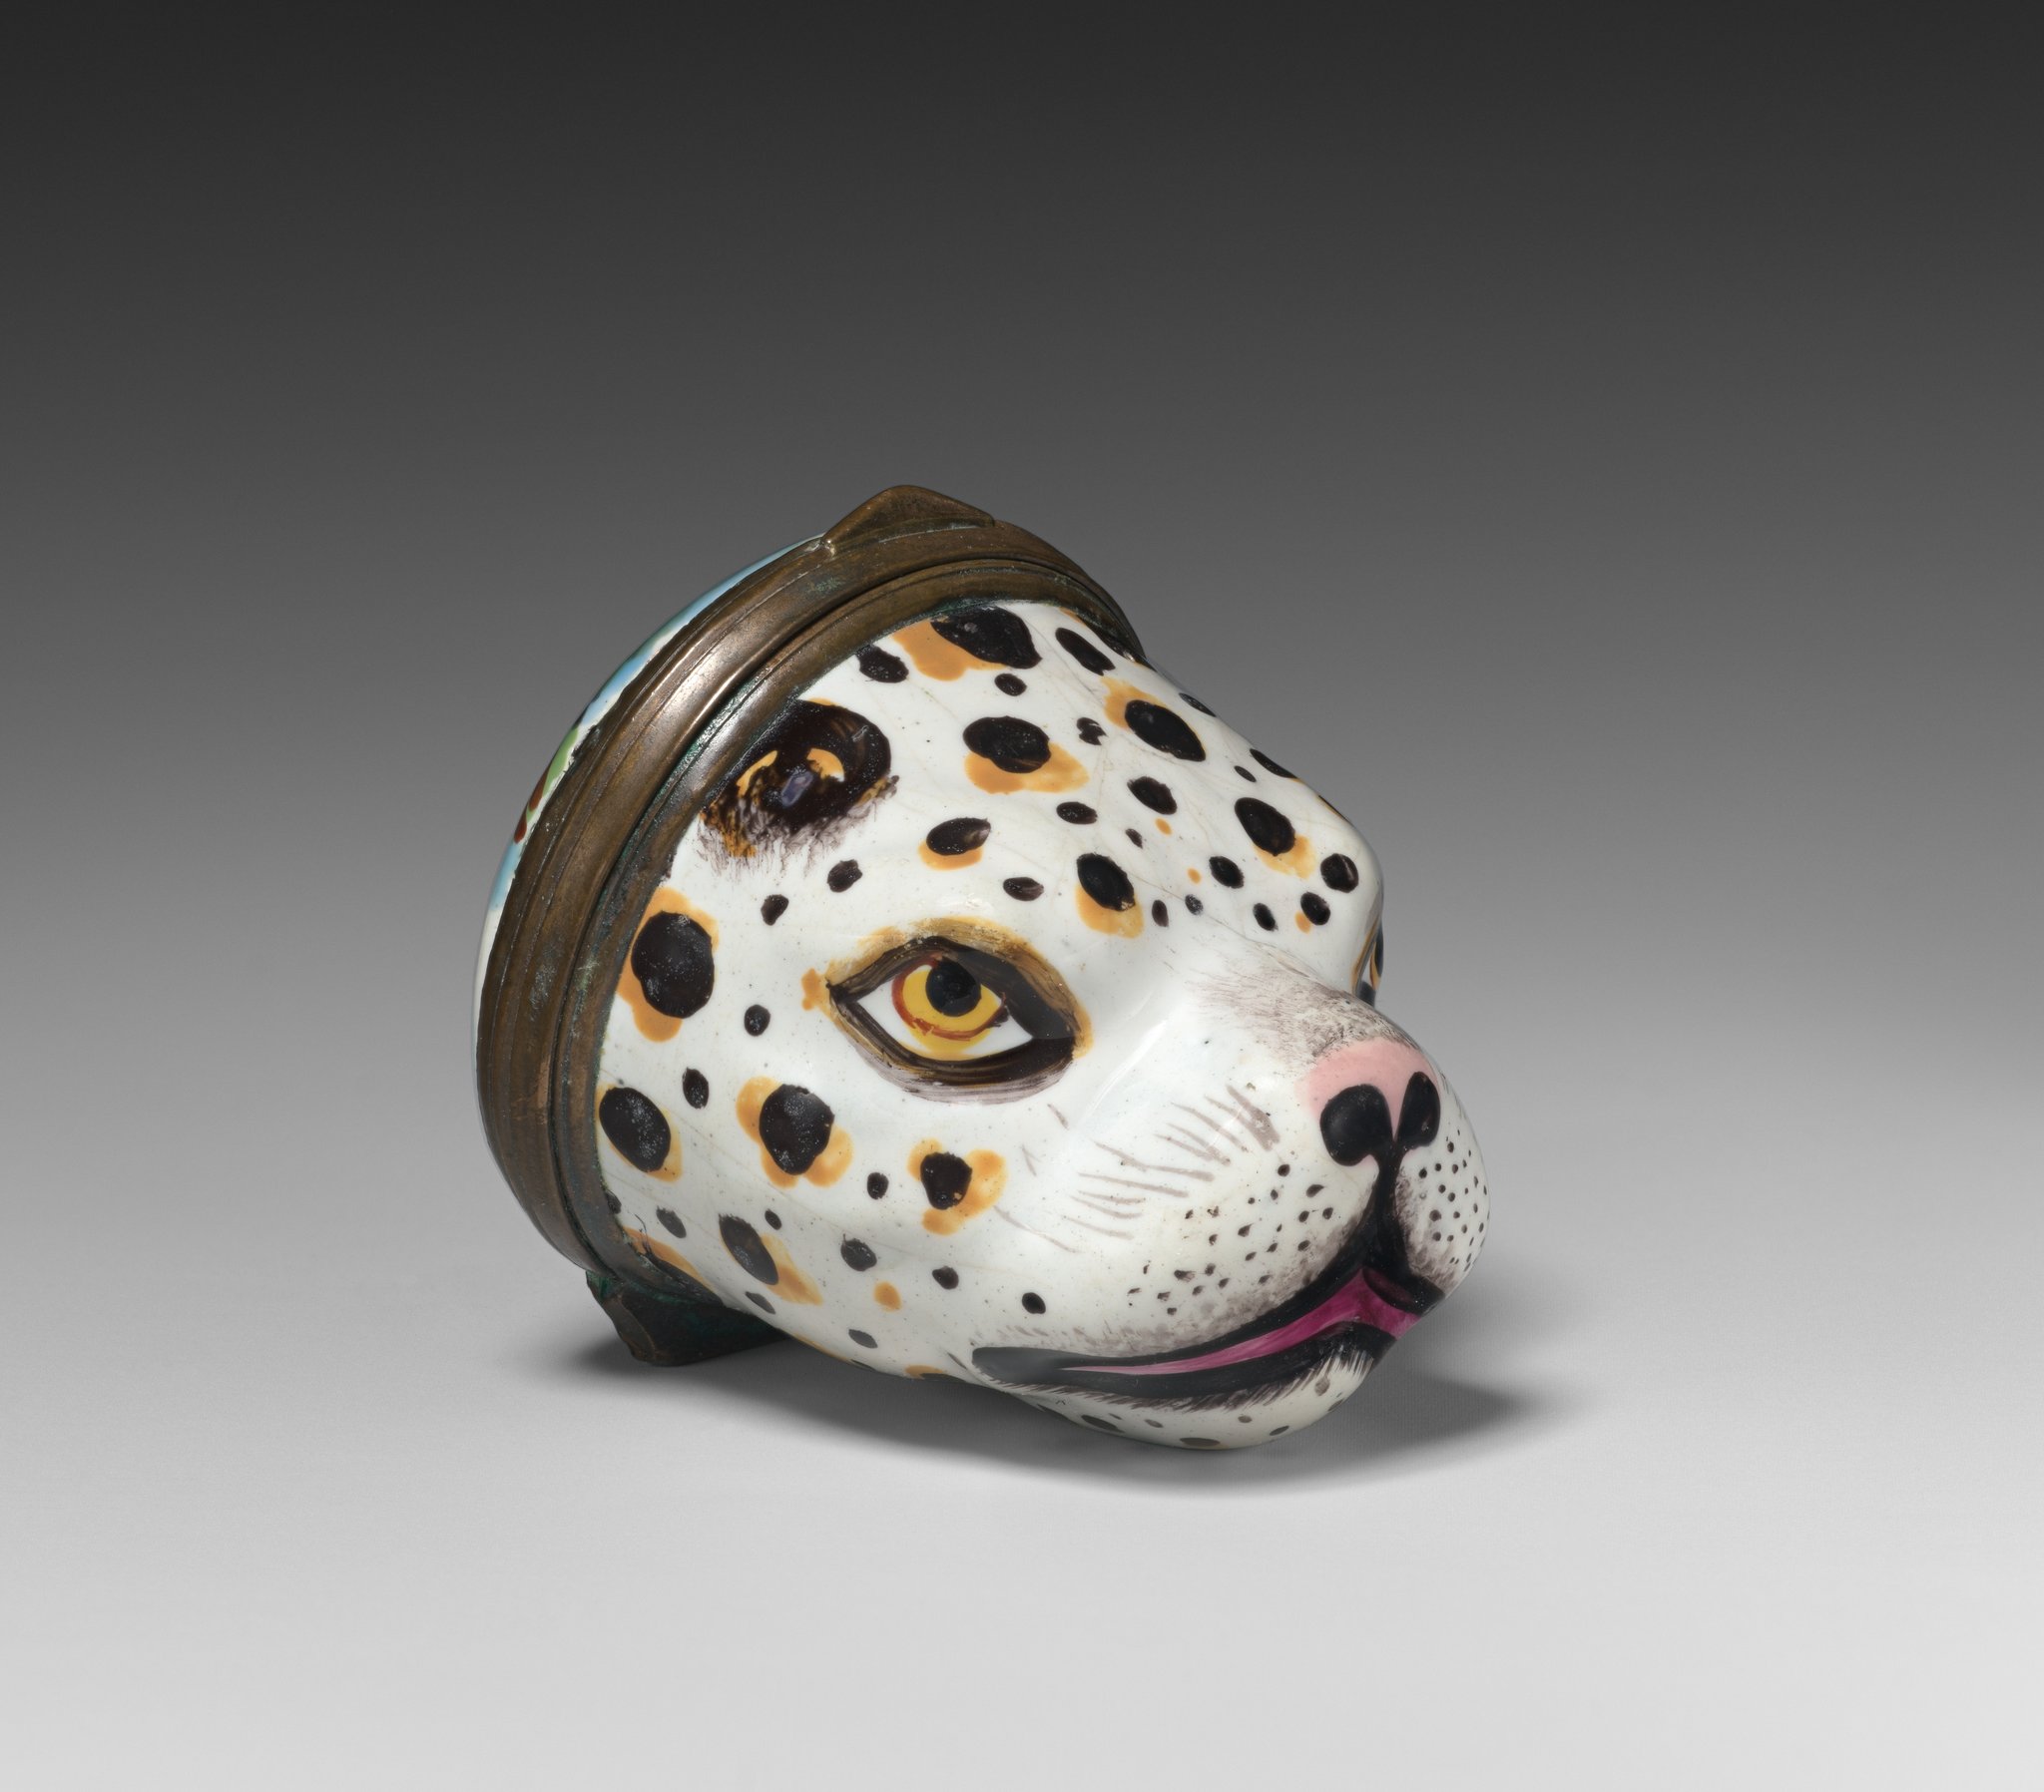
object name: bonbonnière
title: Bonbonnière in the form of a leopard's head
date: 1770-1780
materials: copper, enamel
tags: leopards